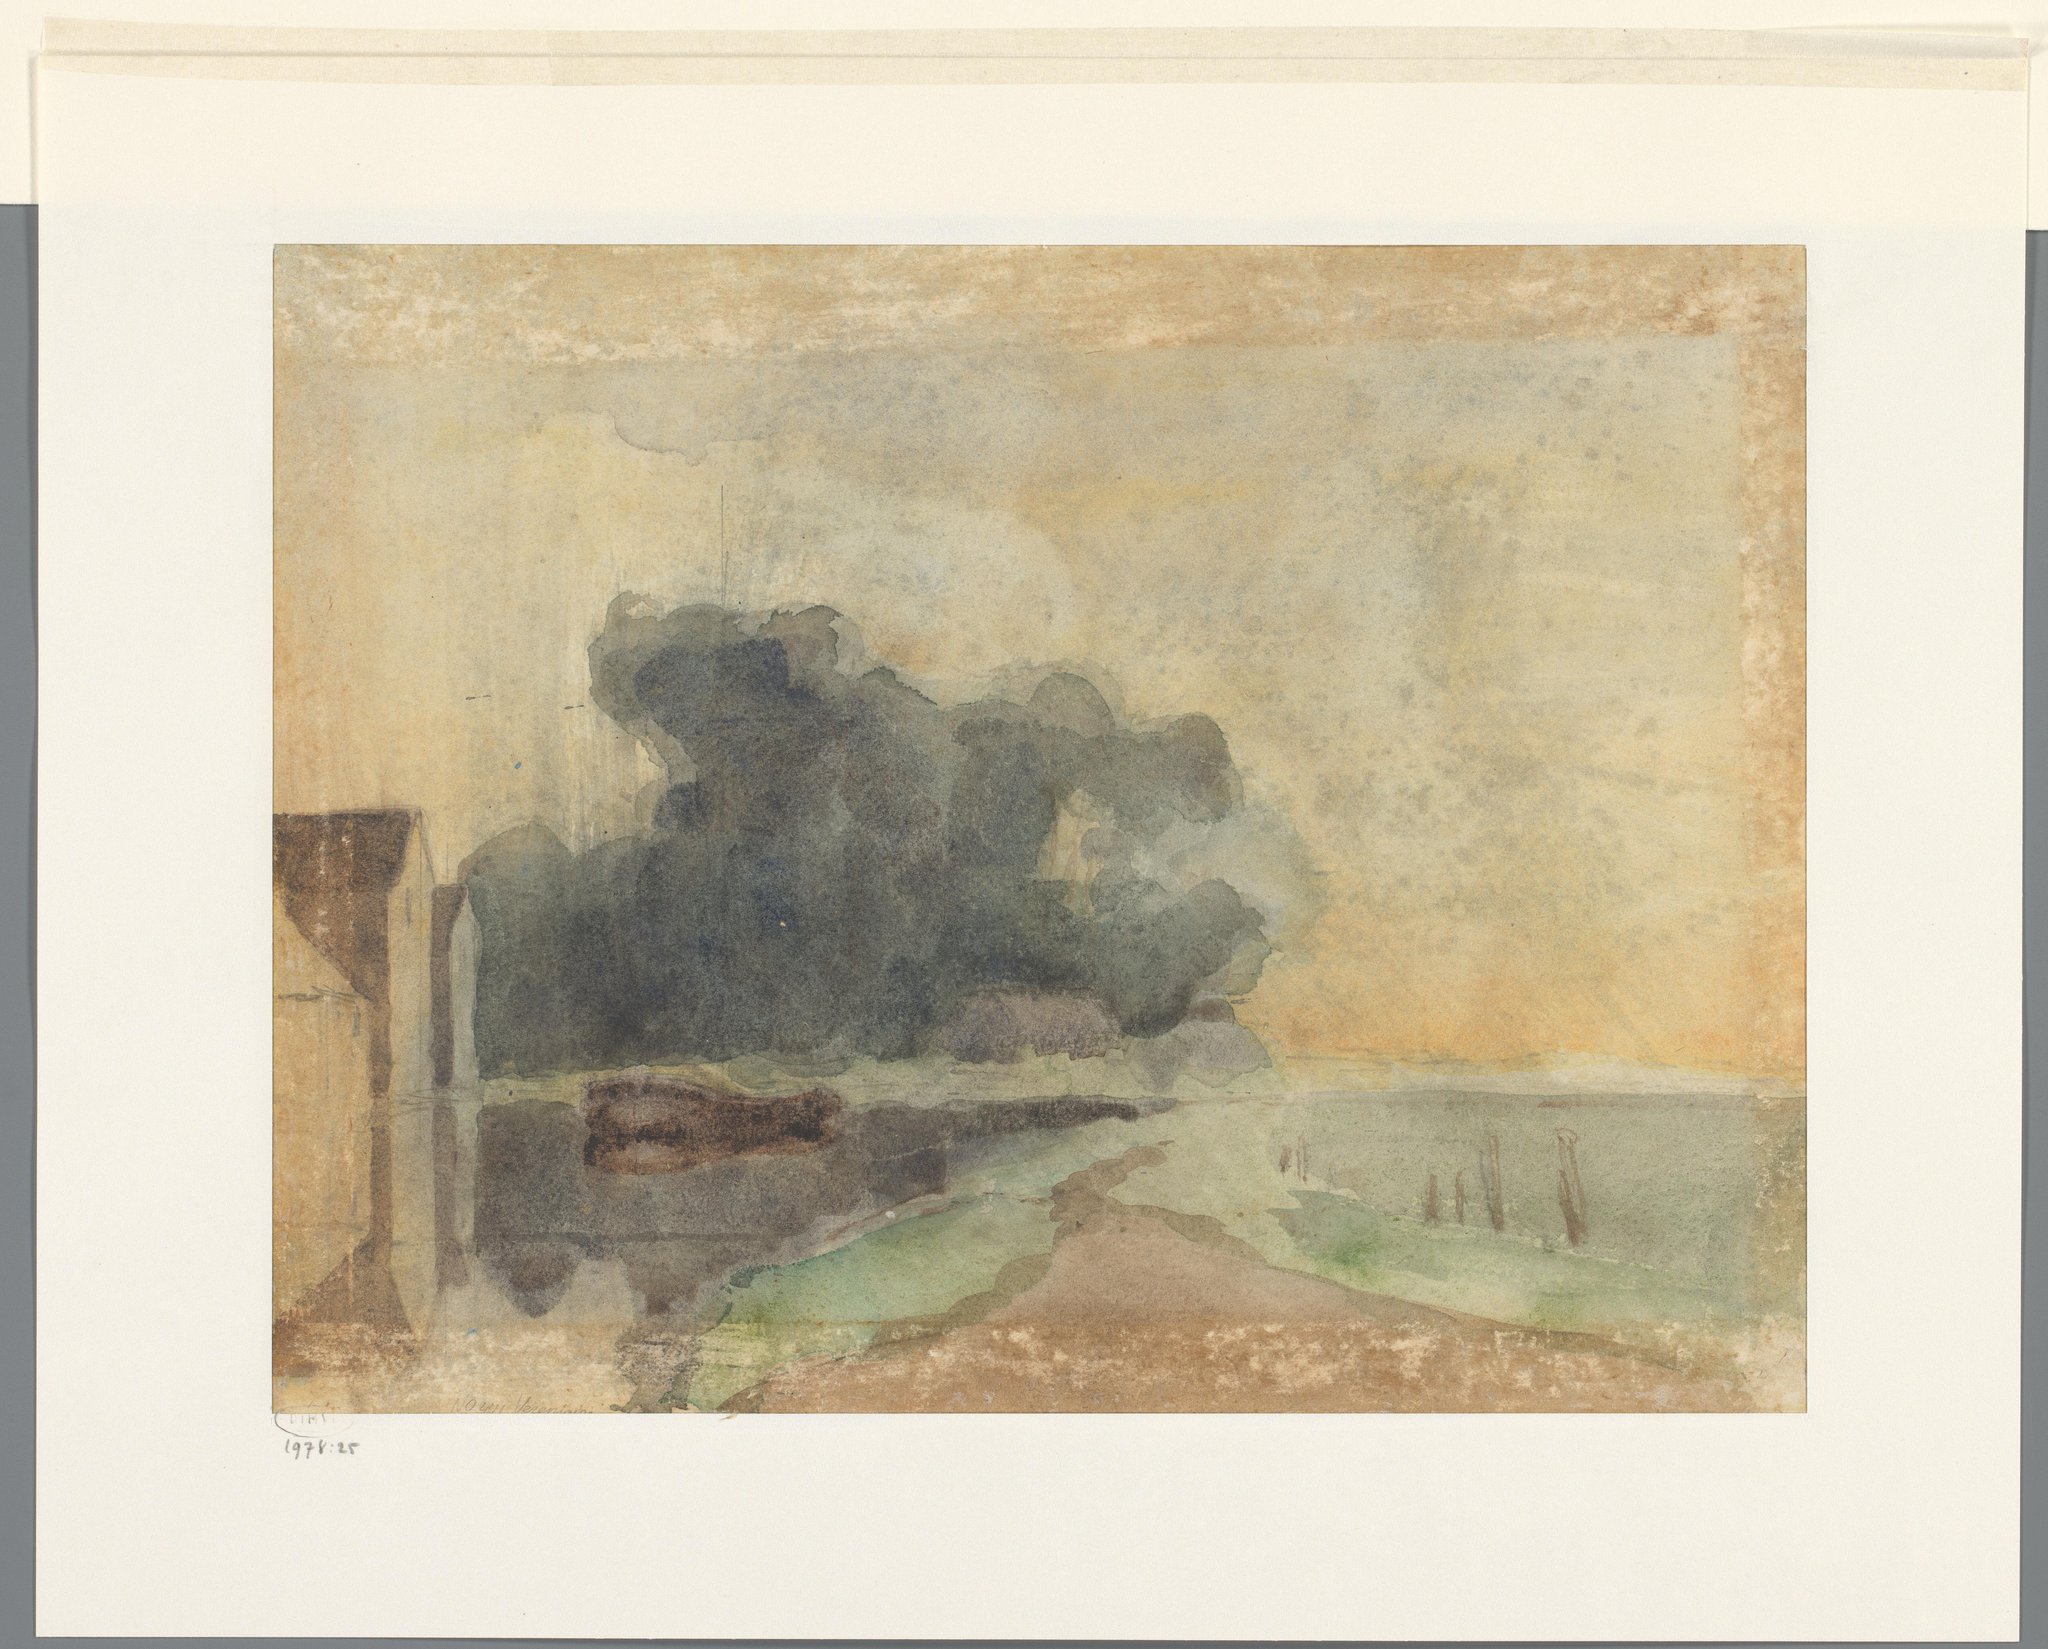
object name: watercolor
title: Landschap met een vaart langs huizen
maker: george hendrik breitner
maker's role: draughtsman, painter, print maker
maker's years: 1857-1923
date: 1867-1923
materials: paper, pencil, watercolor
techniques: brush